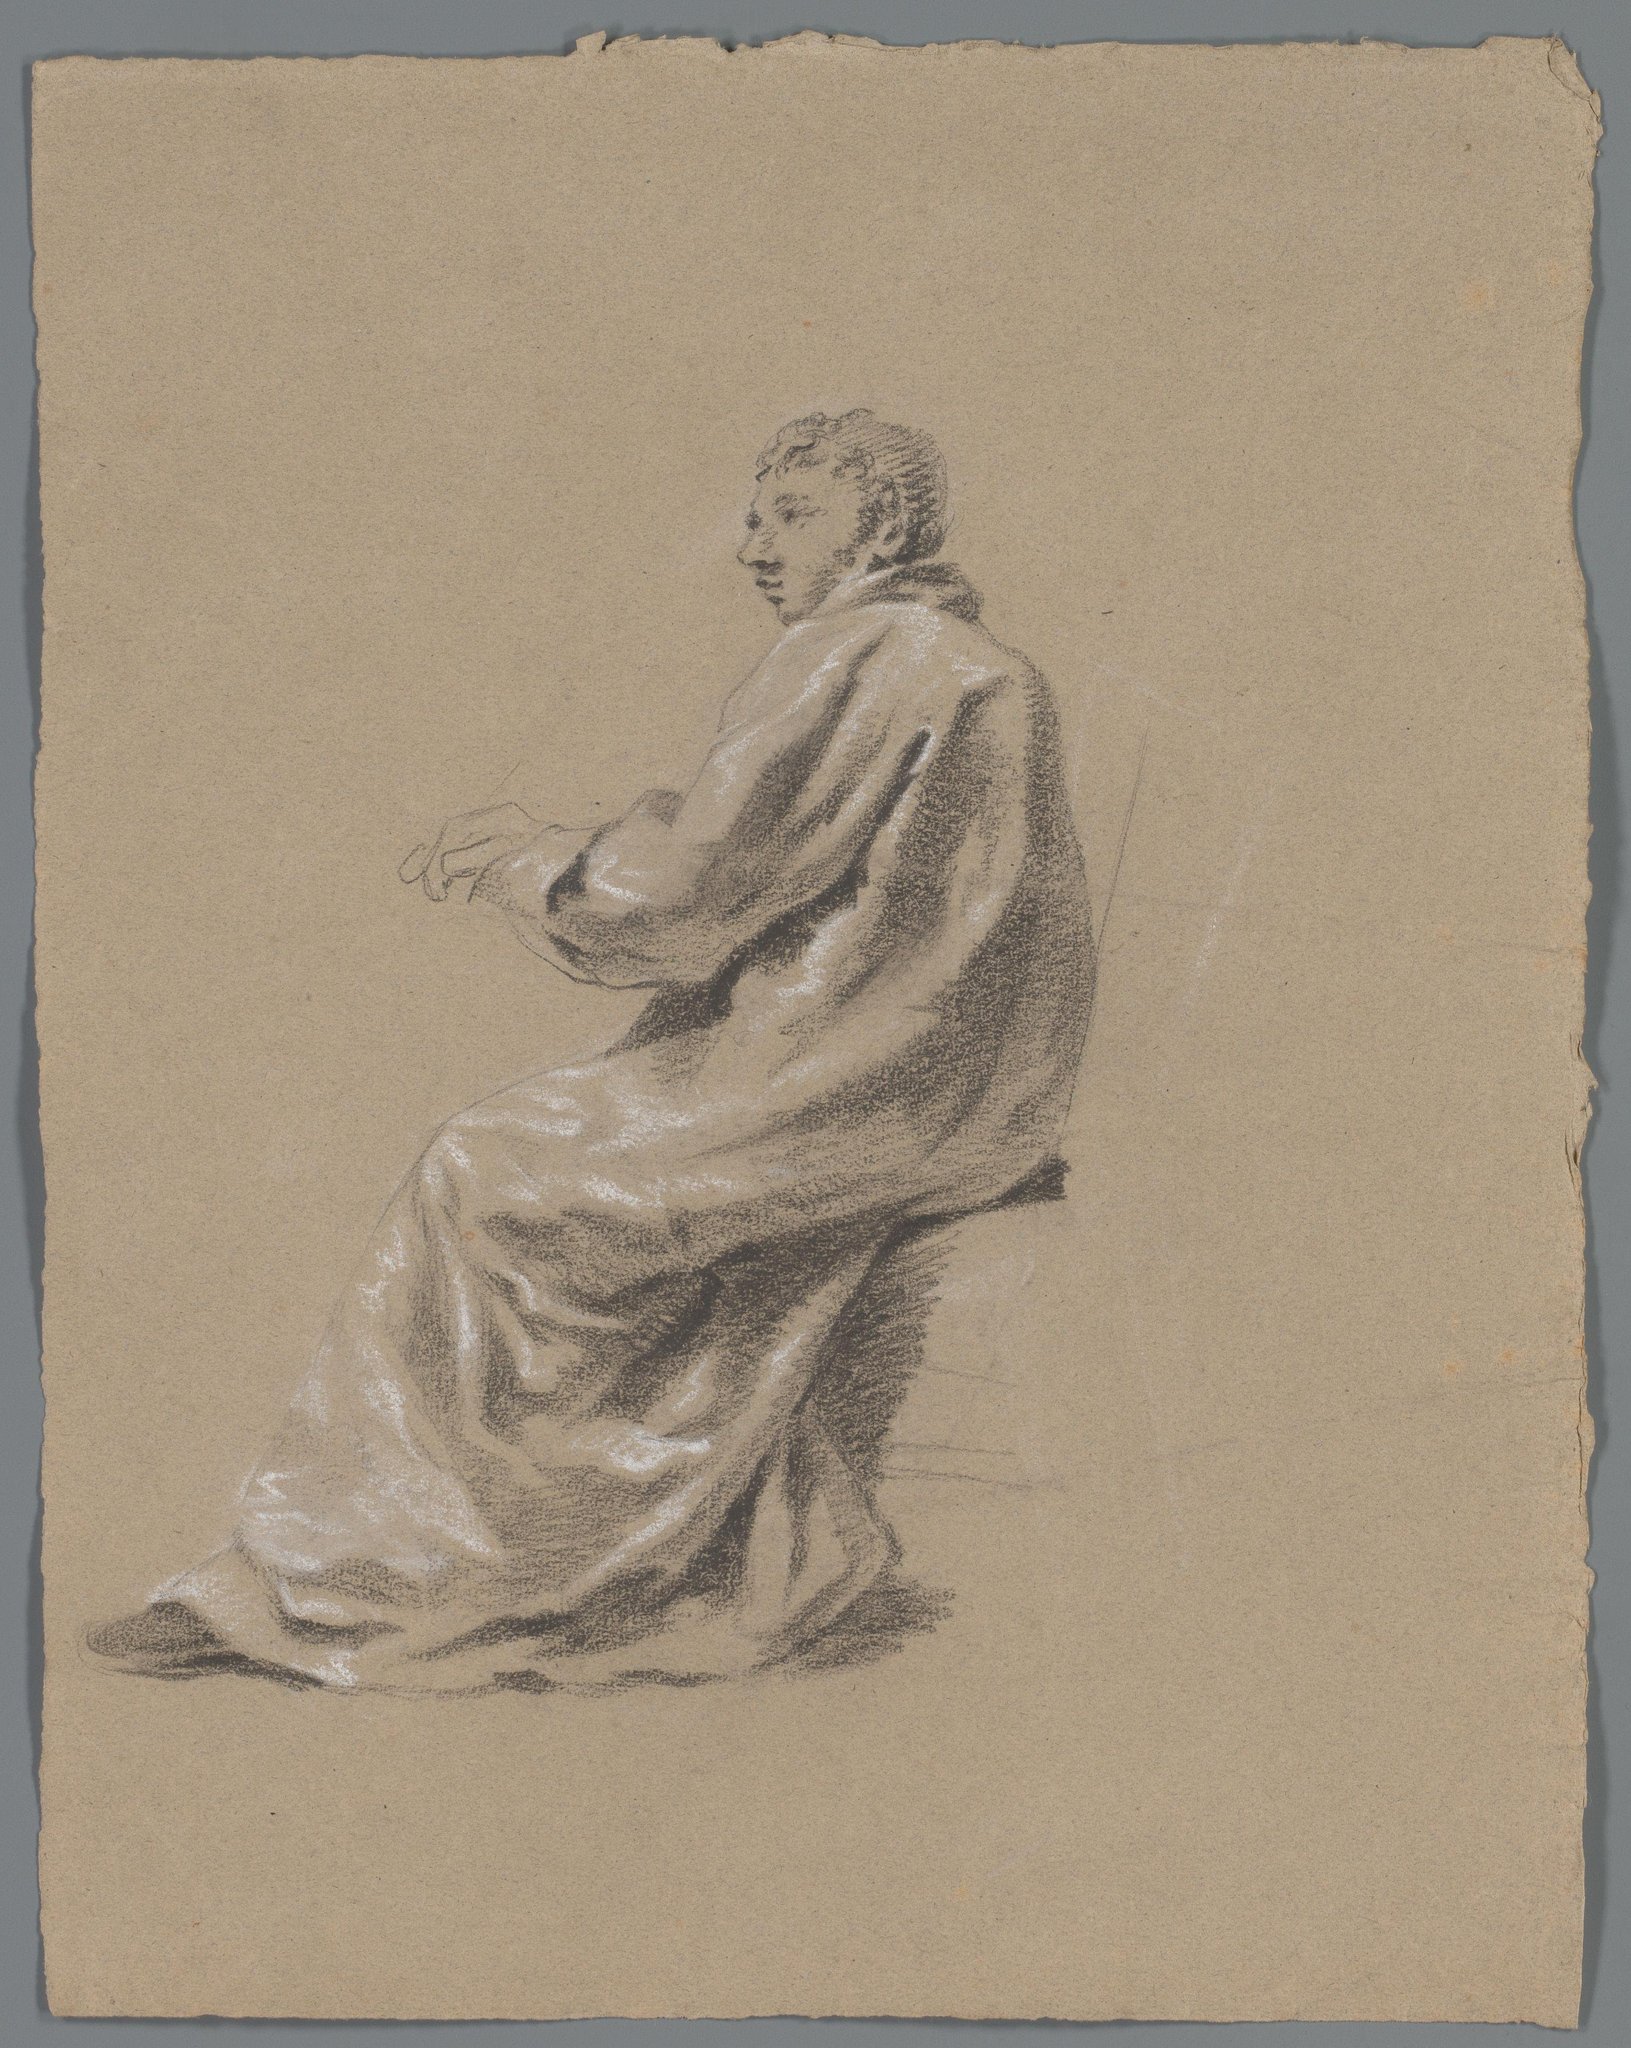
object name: drawing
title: Zittende man in lang gewaad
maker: Anonymous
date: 1820-1830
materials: chalk, paper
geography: the hague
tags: sitting figure, adult man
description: Tekeningen waarschijnlijk ontstaan bij het Haagse kunstgenootschap ‘Tot Nut der Tekenkunst’, waar twee keer per week tekenavonden werden georganiseerd met geklede modellen.